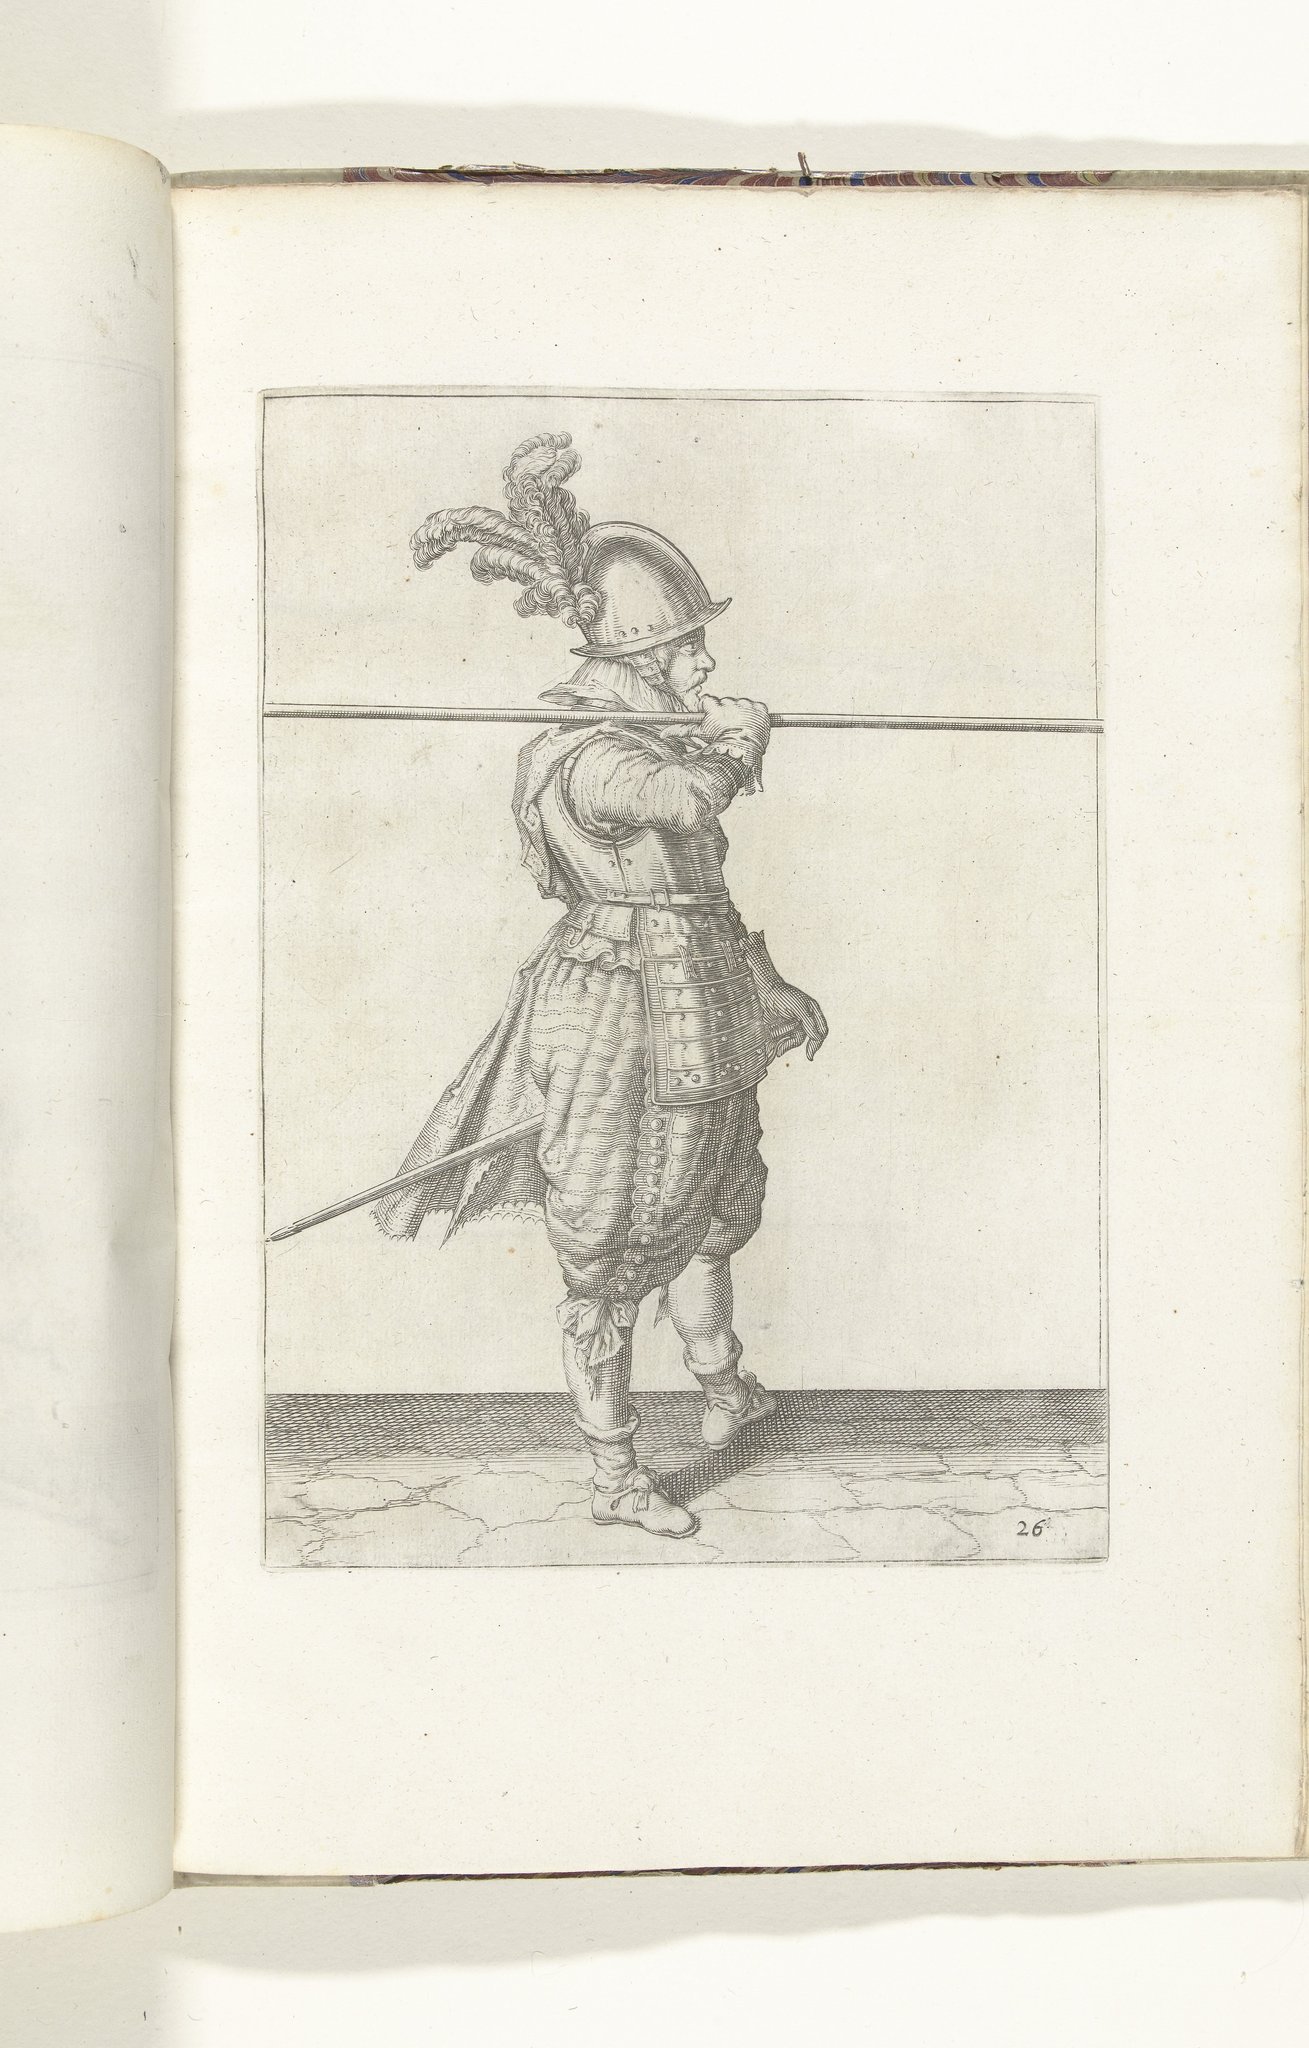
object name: print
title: Soldaat die zijn spies horizontaal op zijn rechterschouder draagt (nr. 26), ca. 1600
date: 1597-1607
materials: paper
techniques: engraving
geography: northern netherlands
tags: maurice (prince of orange), handling of weapons ~ military training, weapons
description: Een soldaat, ten voeten uit, naar rechts, die een spies (lans) horizontaal op zijn rechterschouder draagt. Zijn rechterhand om de spies (nr. 26), ca. 1600. Eerst fout genummerd 24, dit cijfer hier verbeterd in 26. Plaat 26 in de instructies voor het hanteren van de spies: Corte onderwysinghe op de figuerliicke afbeeldinghe belanghende trechte gebruck, van alle t'ghene een Soldaet int handelen vande Spies noodich is. Onderdeel van de illustraties in: J. de Gheyn, Wapenhandelinghe van Roers Musquetten ende spiessen, Amsterdam, 1608. Krijgswezen rond 1600.